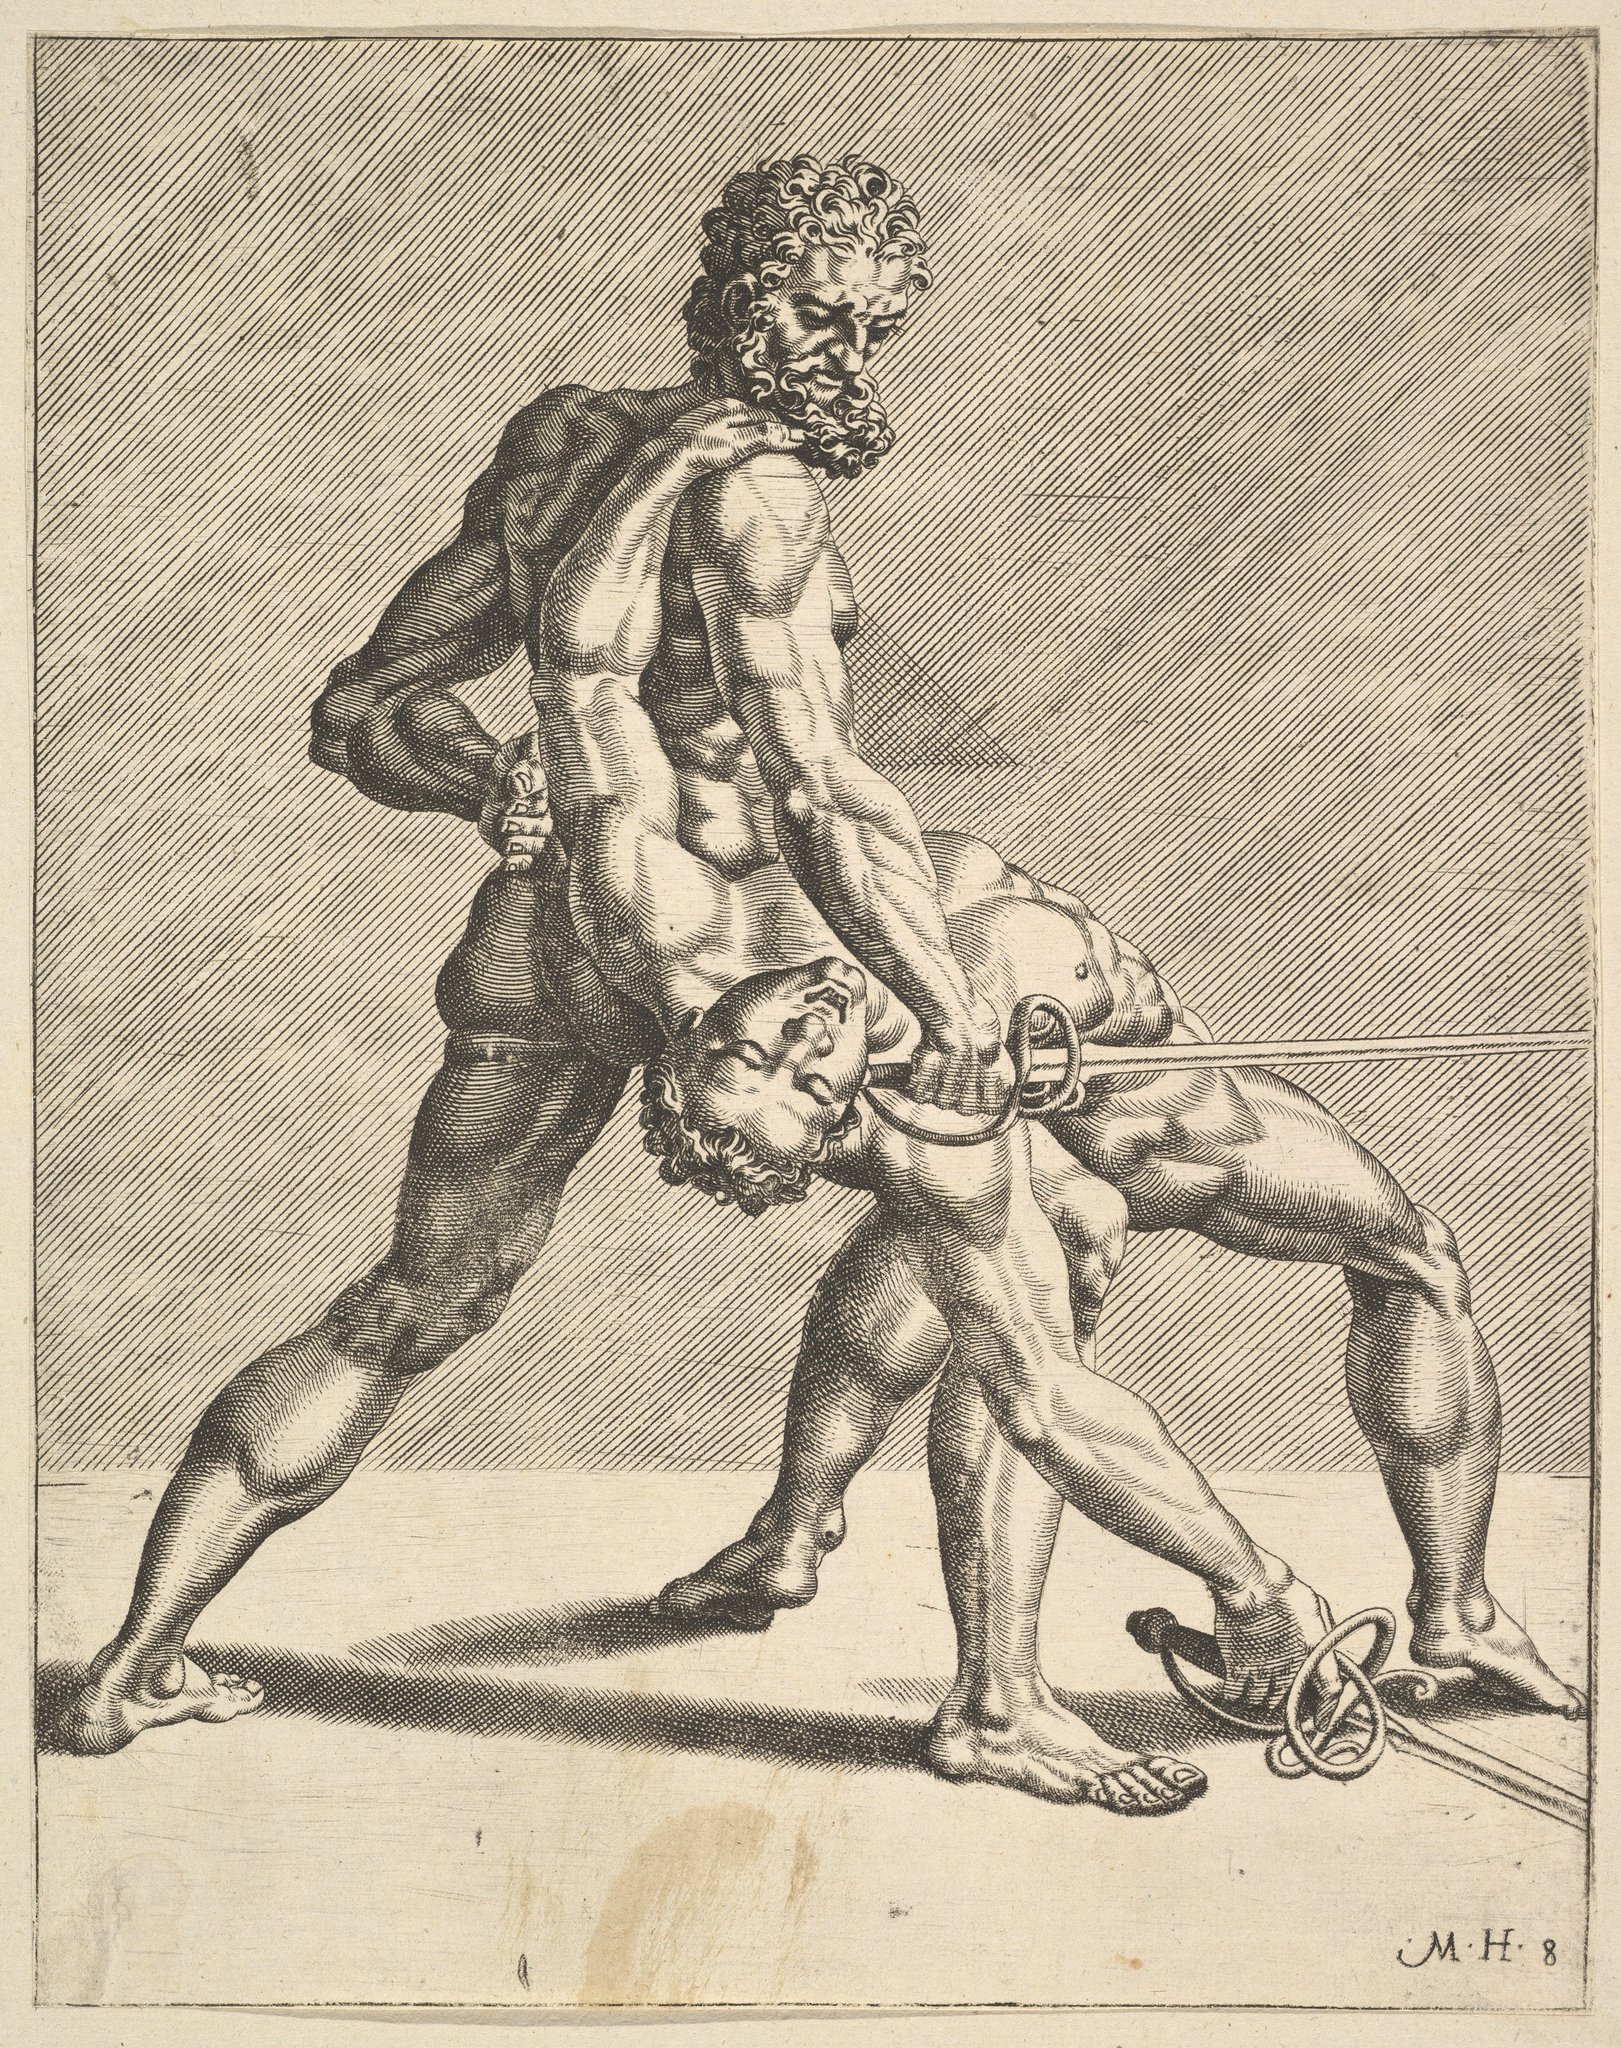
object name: print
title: Two Fencers, from Fencers, plate 8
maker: dirck volckertsz coornhert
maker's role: artist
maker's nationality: netherlandish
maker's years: 1519-1590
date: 1552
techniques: engraving, etching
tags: swords,male nudes,fencing